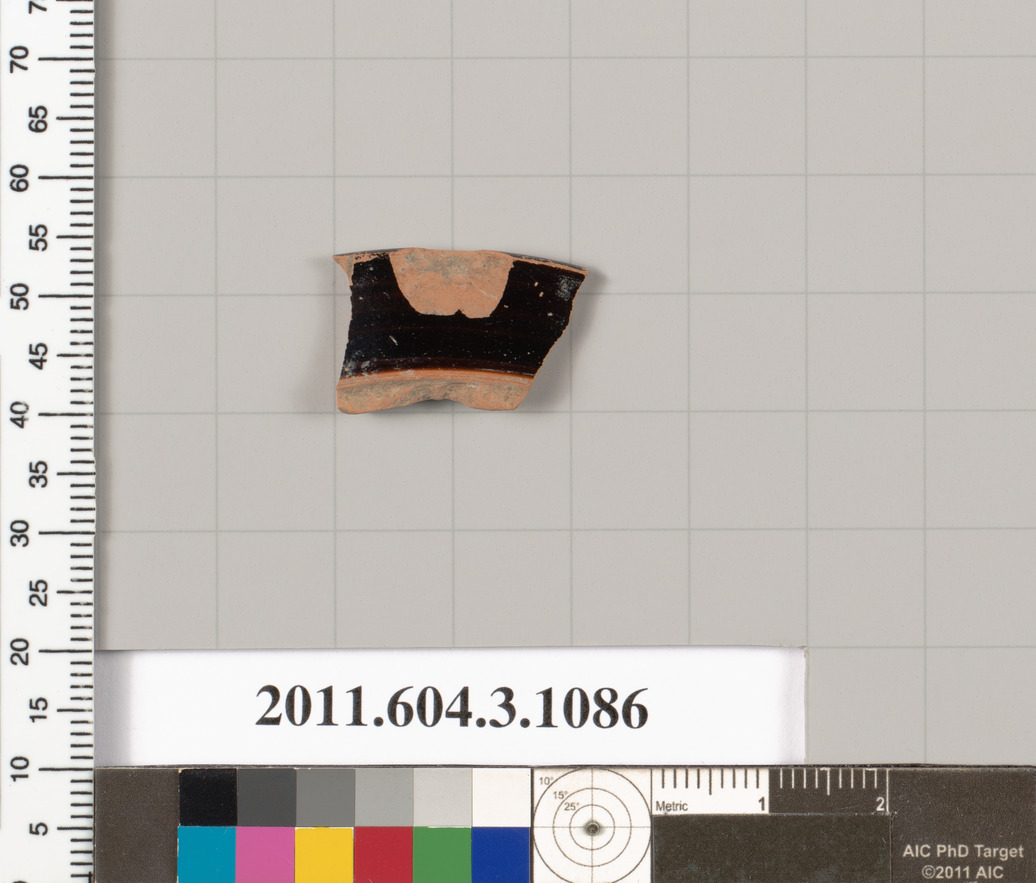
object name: mastoid fragment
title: Terracotta rim fragment of a mastoid (drinking cup with narrow base)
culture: greek, attic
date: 534-468 BCE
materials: terracotta